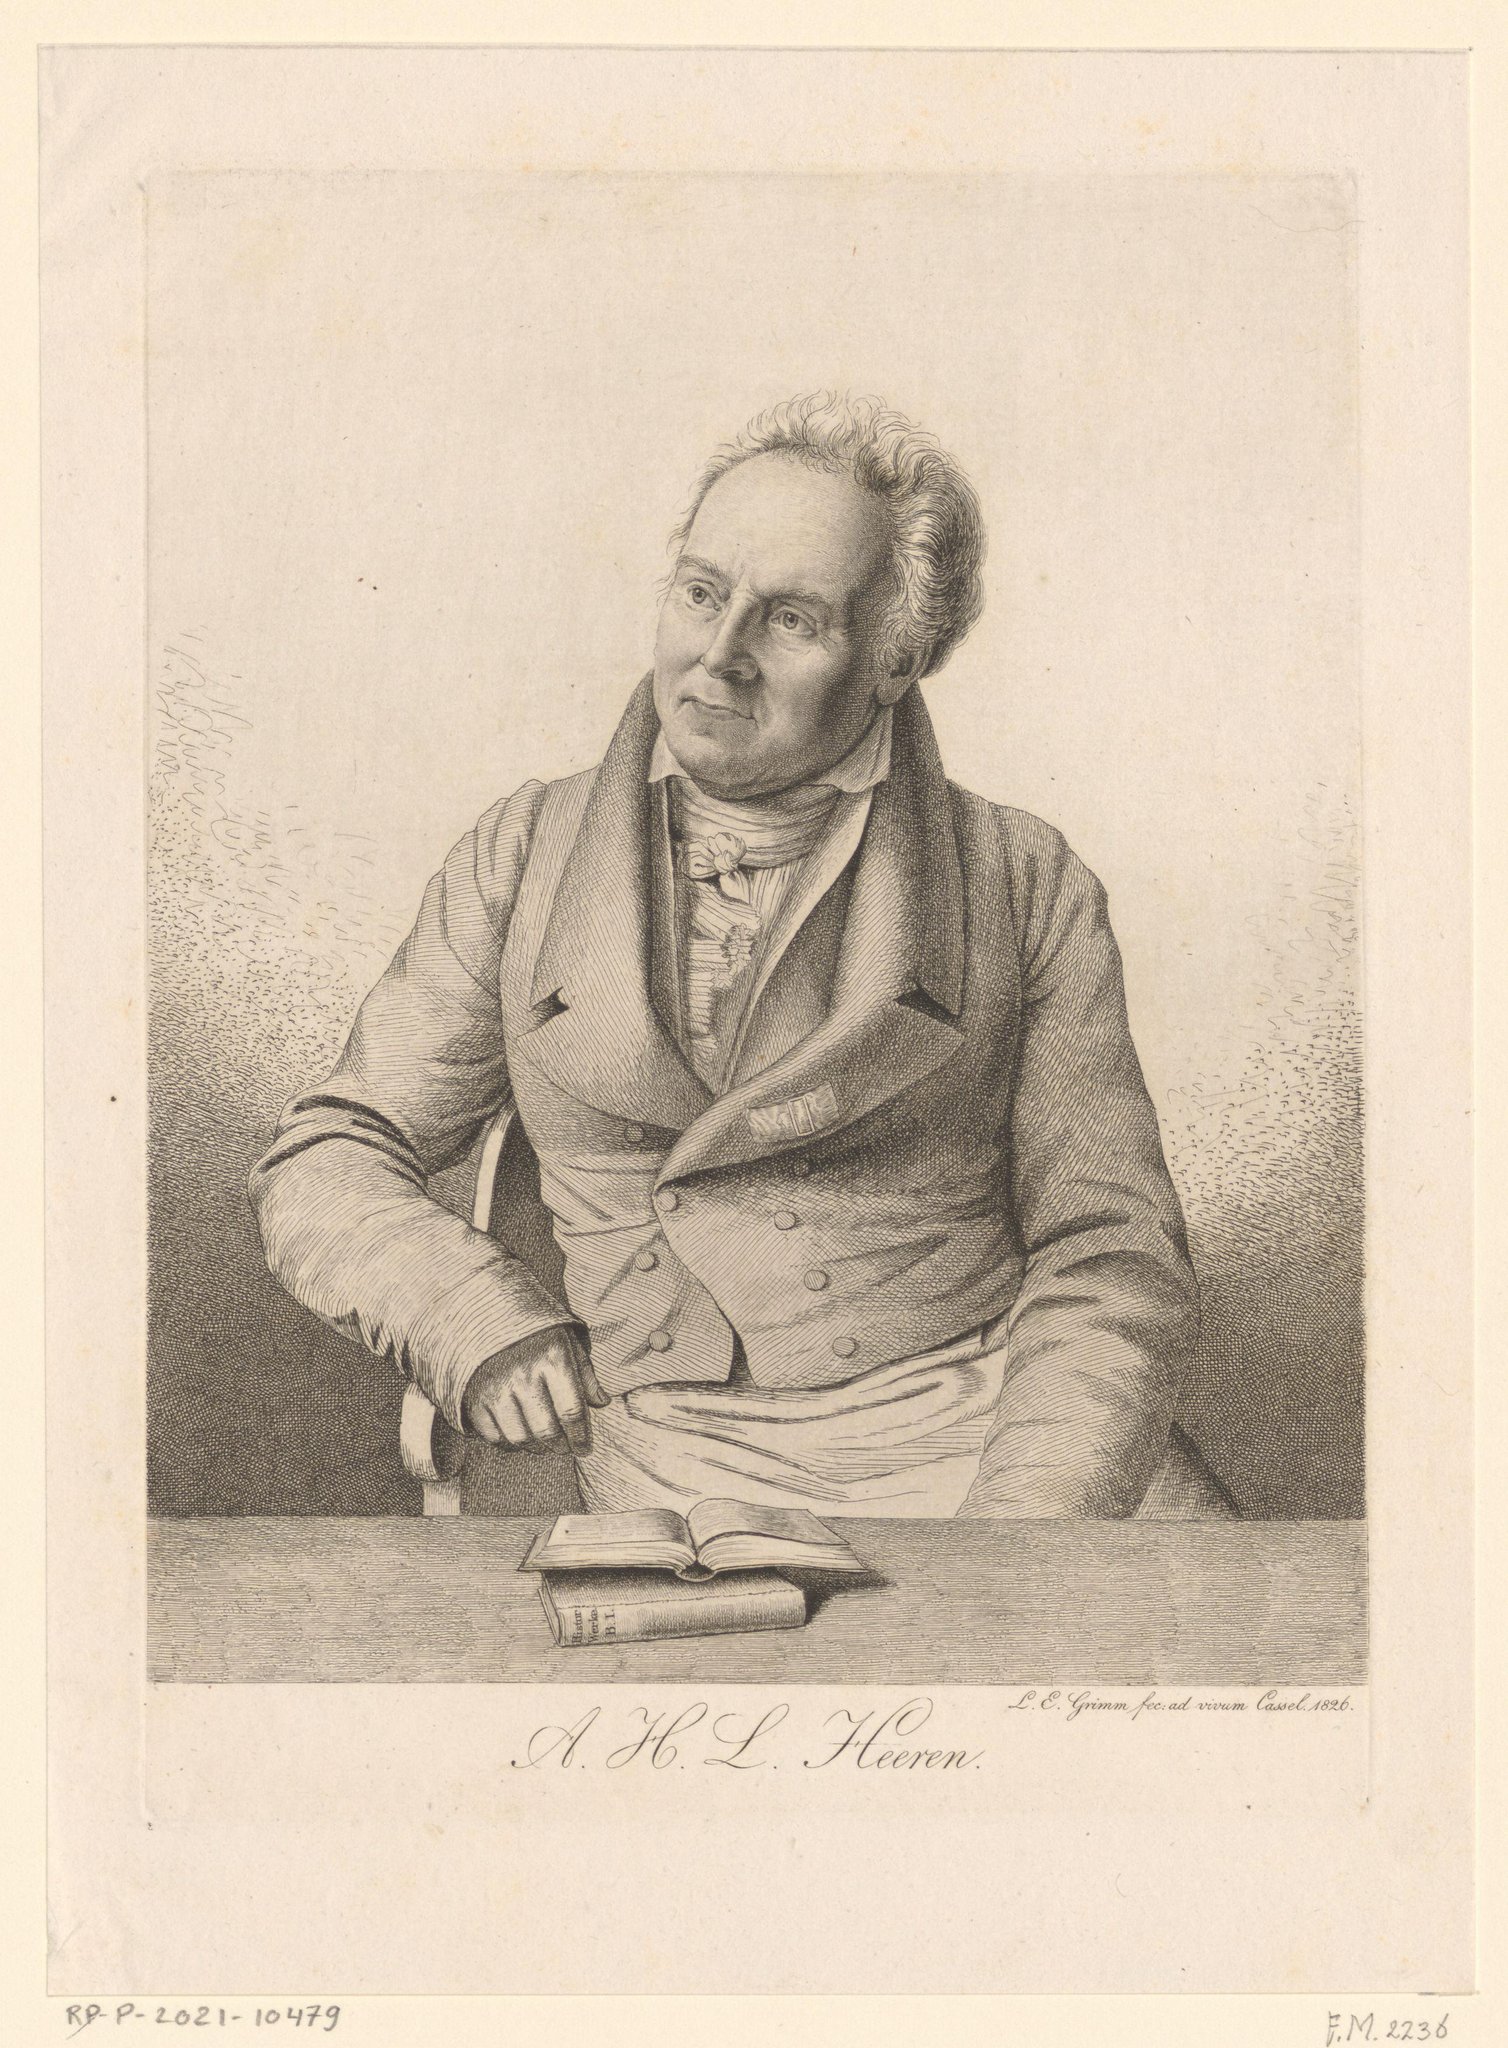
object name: print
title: Portret van Arnold Hermann Ludwig Heeren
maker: ludwig emil grimm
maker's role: print maker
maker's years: 1790-1863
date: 1826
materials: paper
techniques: etching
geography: cassel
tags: historical persons, book, professor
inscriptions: collector's mark: Lugt 2228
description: Op het opzetvel is een blad geplakt met daarop de handtekening van Heeren, een strookje met de tekst: 'Geassocieerde van de 3e klasse van het Koninklijk-Nederlandsche Instituut, benoemd 1809. Overl. 1842' en een strookje met biografische gegevens.